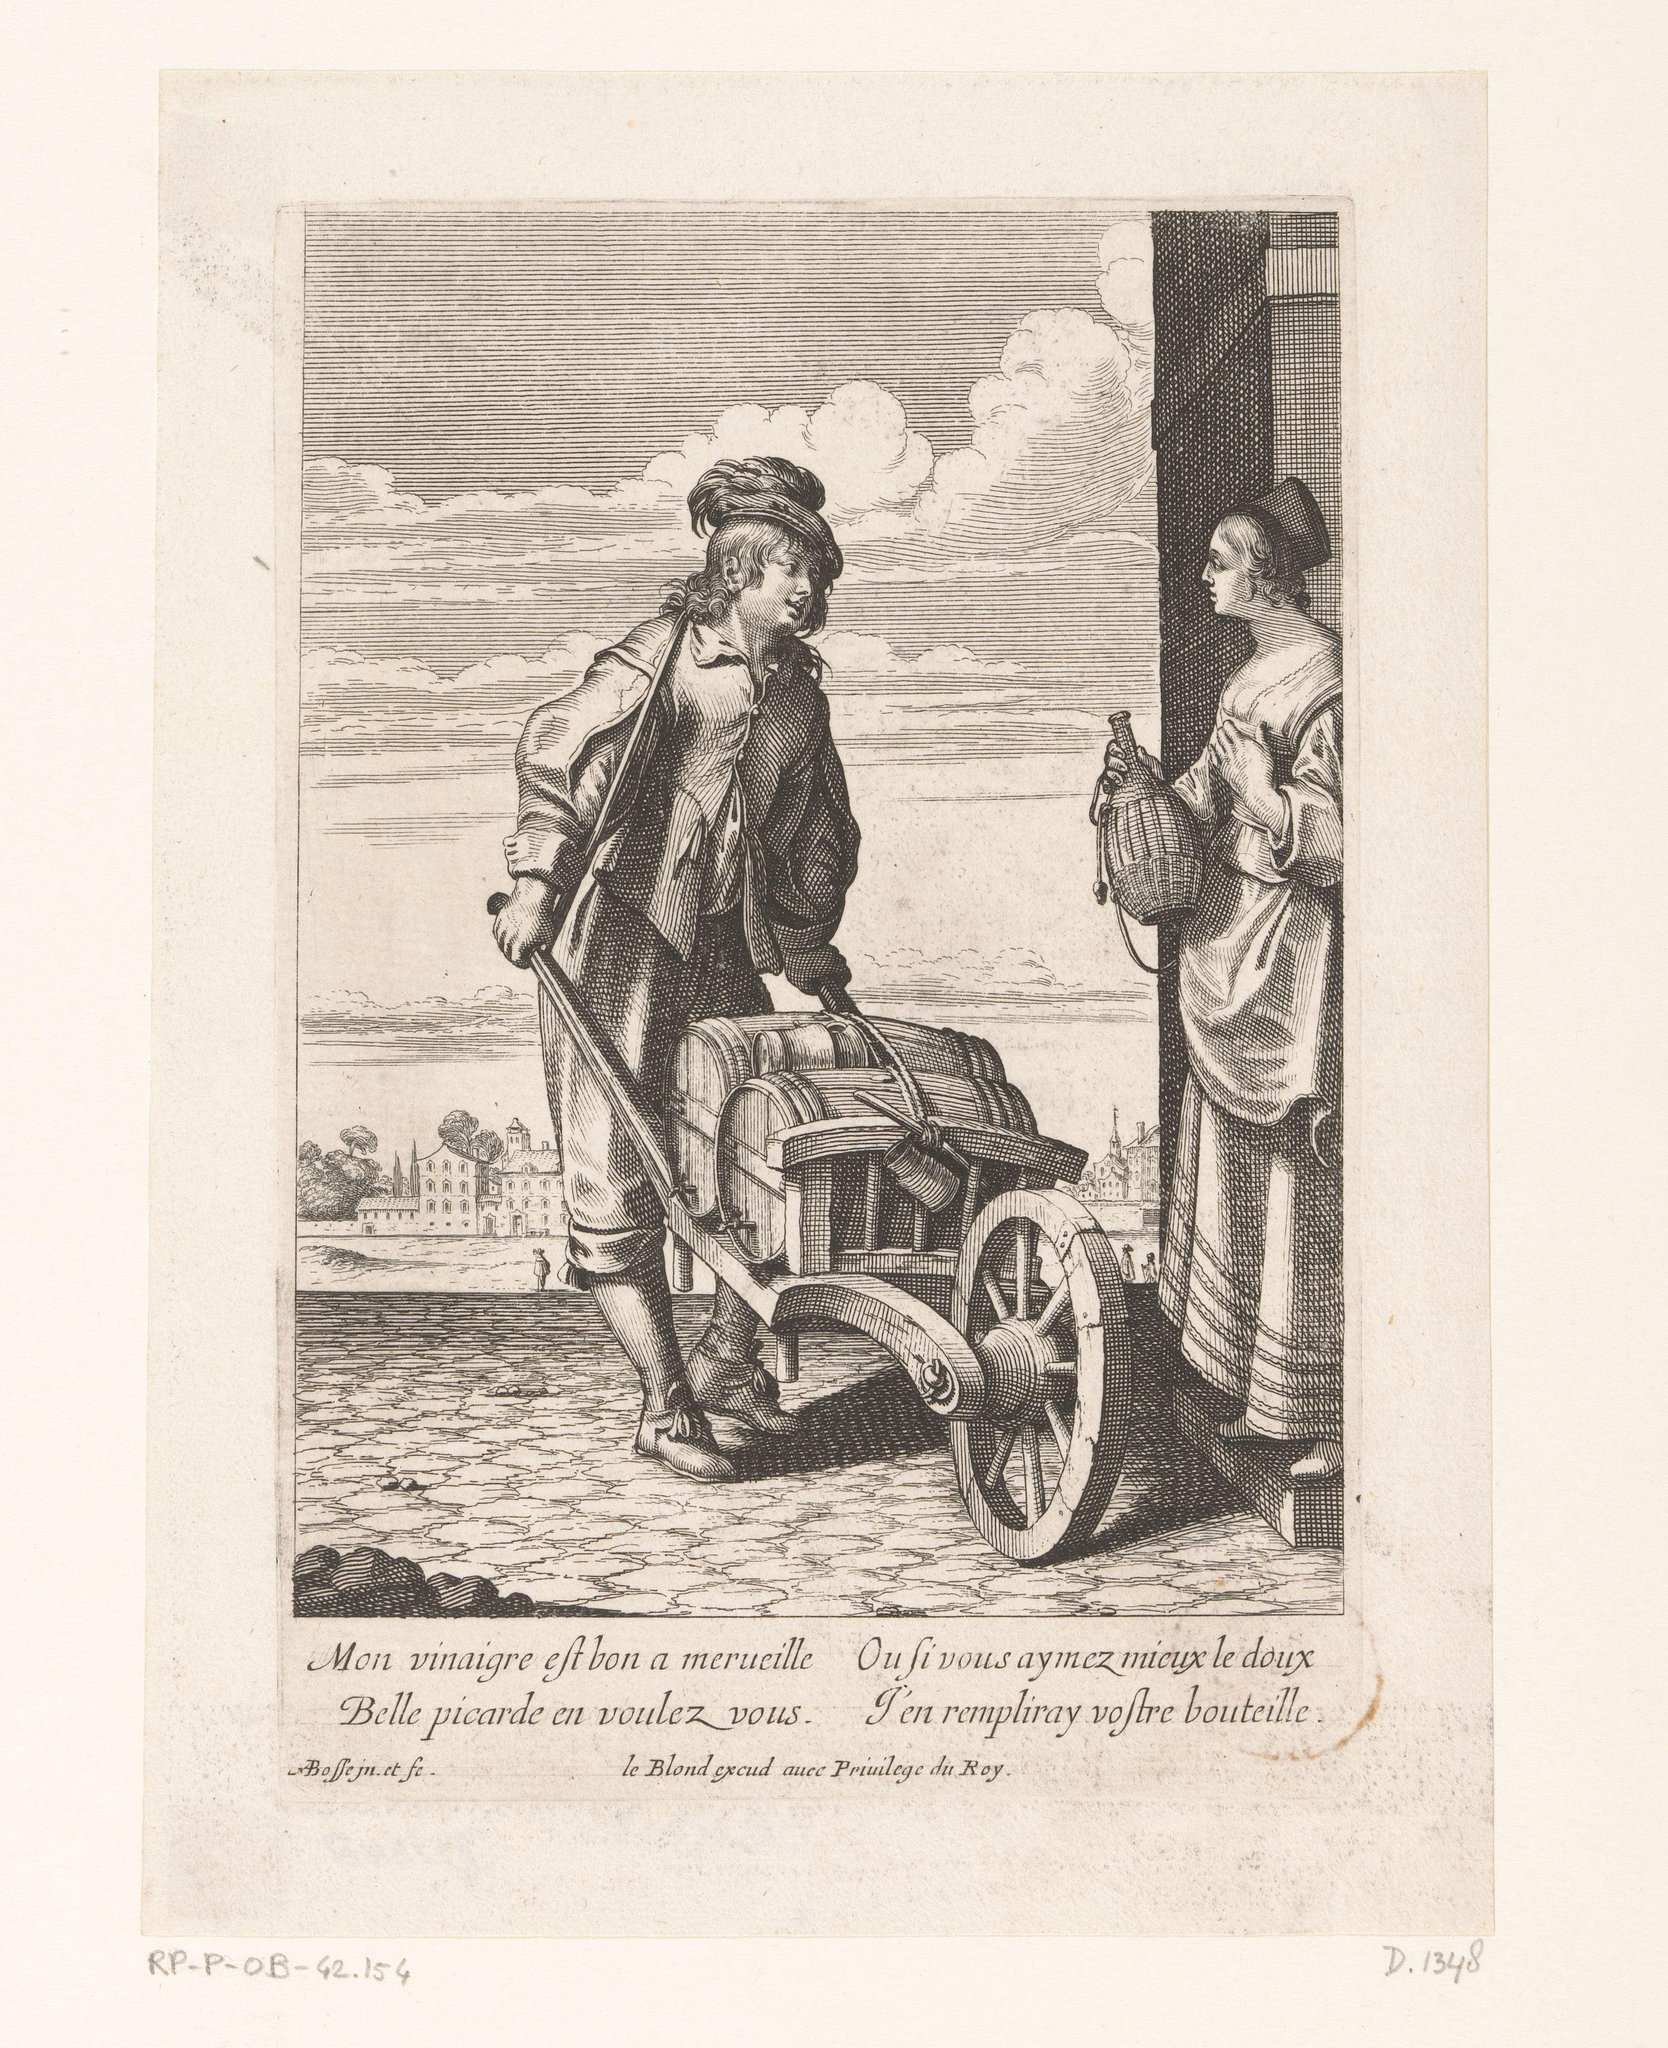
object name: print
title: Les cris de Paris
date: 1629-1630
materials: paper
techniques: engraving, etching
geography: paris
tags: vinegar, wandering or travelling merchant, wheelbarrow, merchant, salesman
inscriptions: collector's mark: Lugt 240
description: Maakt deel uit van een serie van twaalf prenten met straatverkopers en dienstverleners, uitgegeven door Jean Leblond (I) tussen 1629-1630 te Parijs.